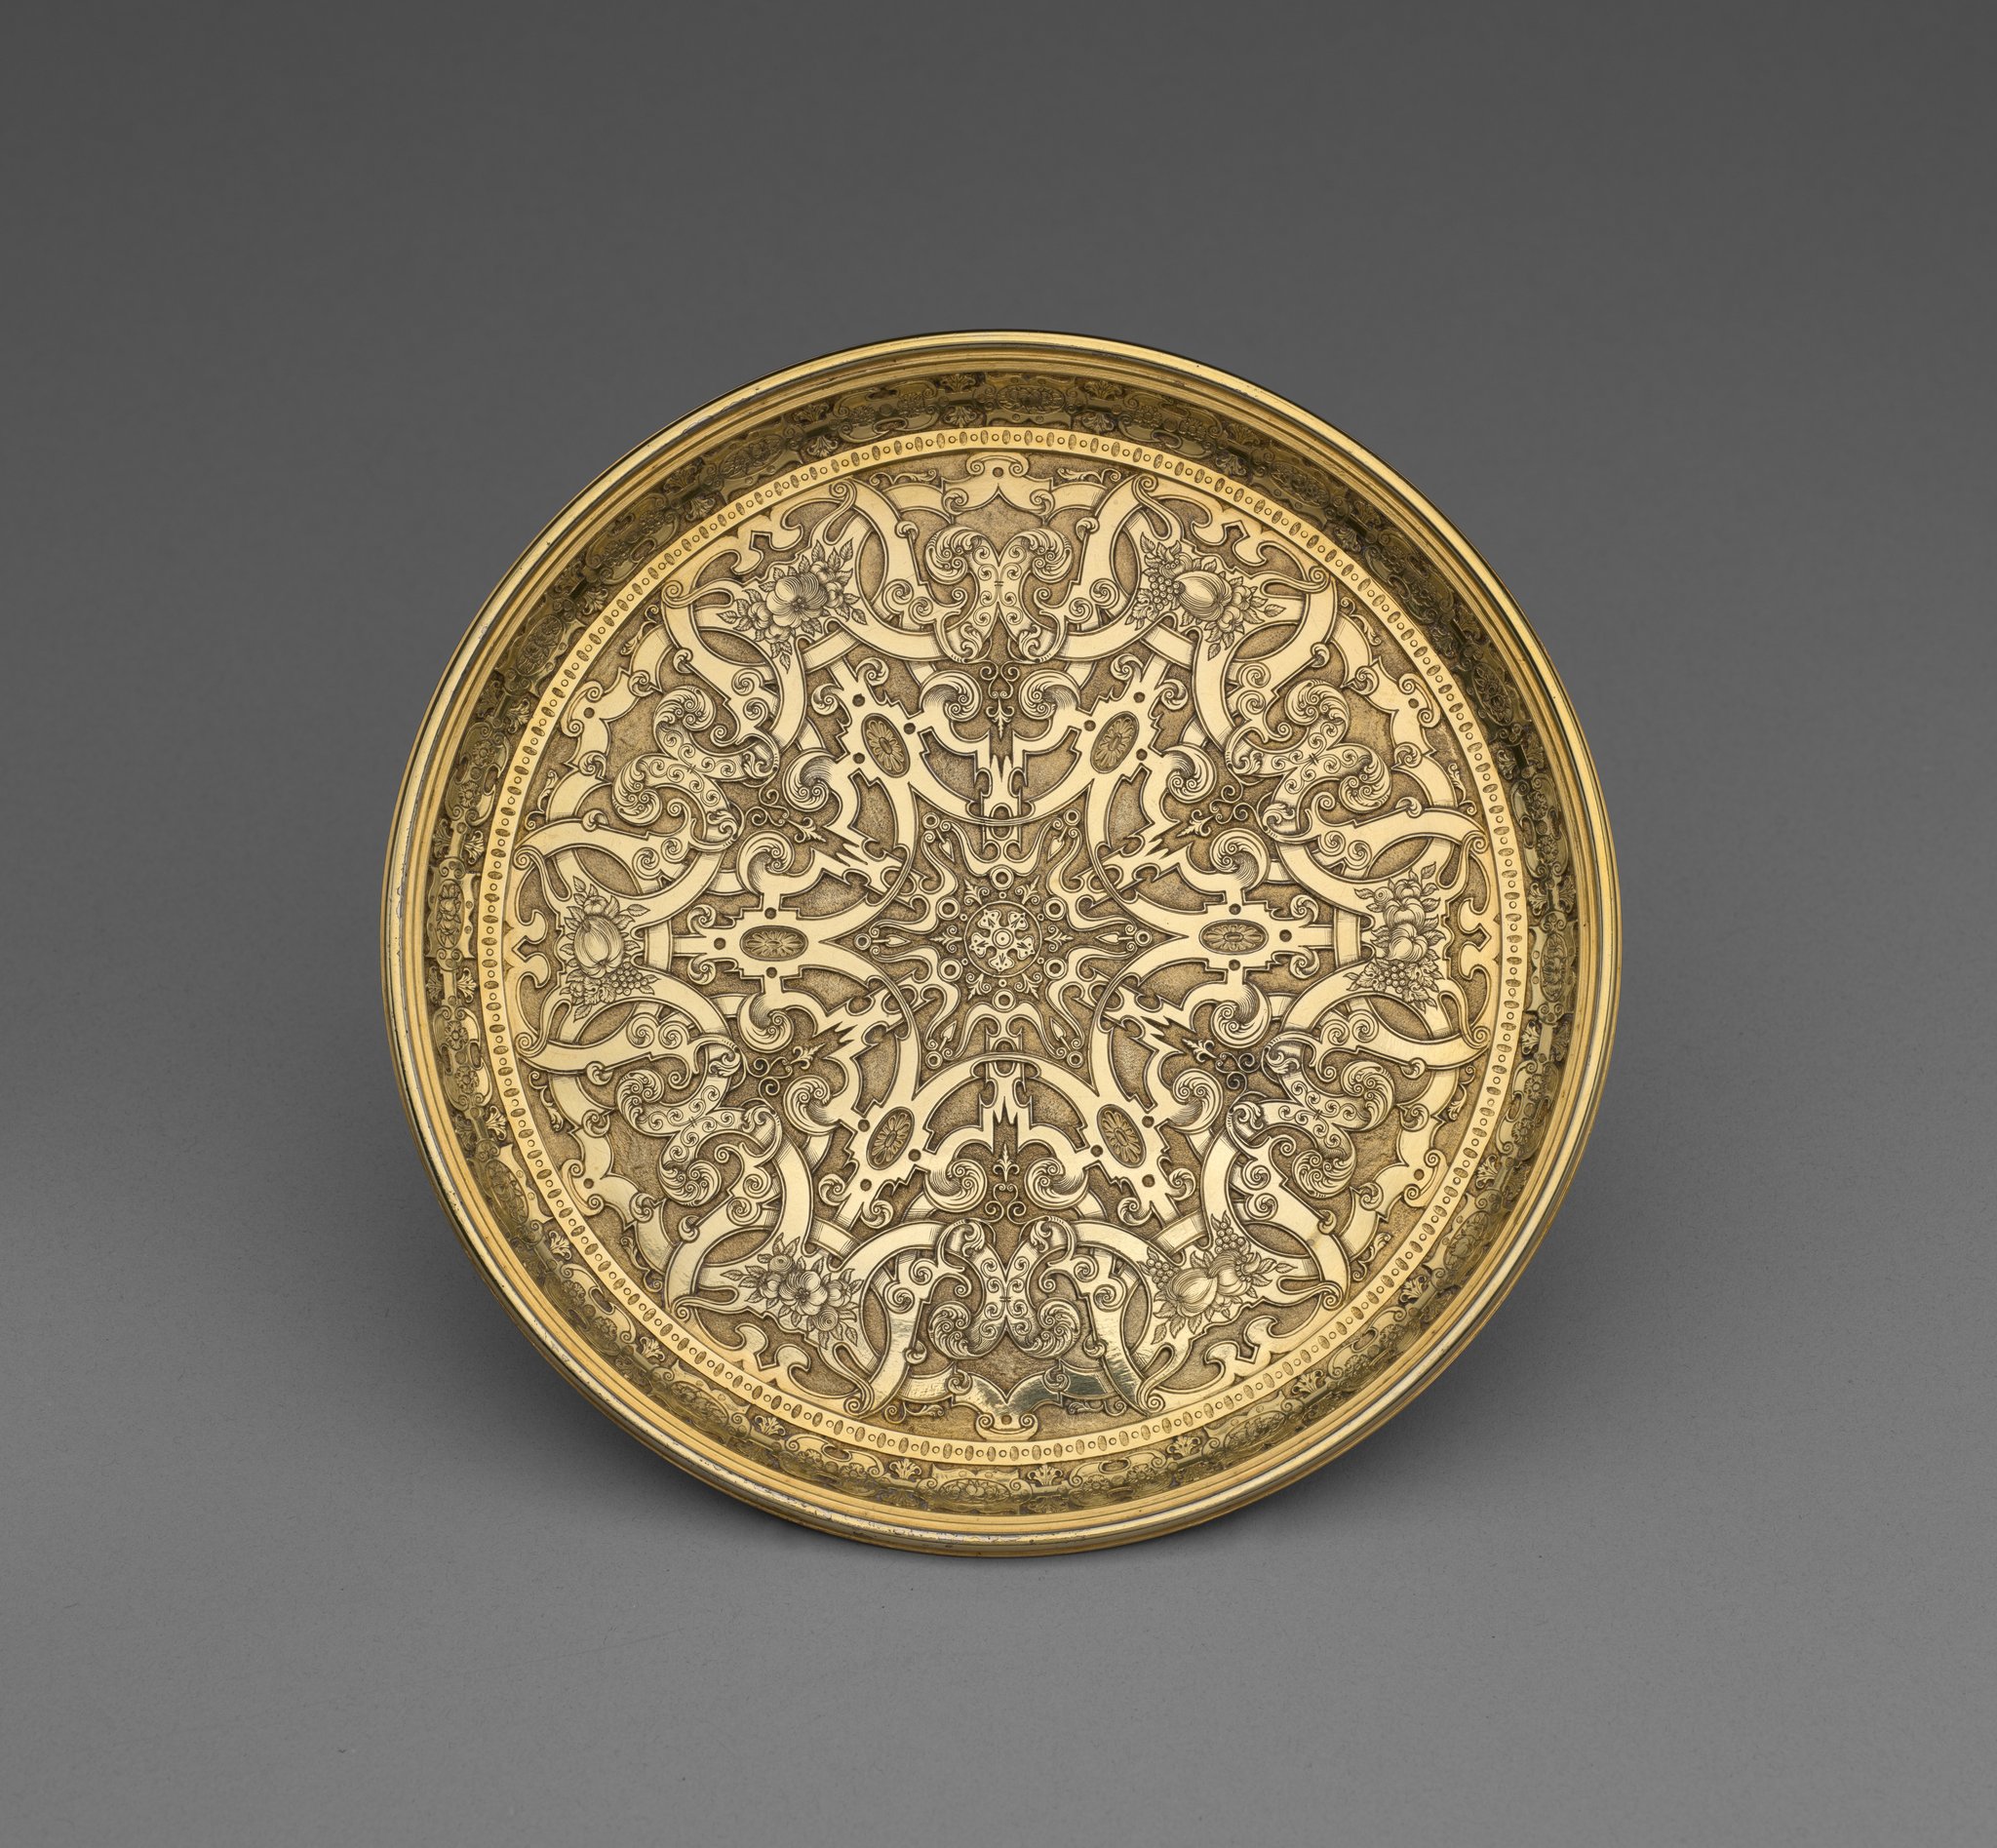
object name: waiter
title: Waiter (one of a pair)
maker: william burwash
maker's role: maker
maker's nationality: british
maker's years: 1782-1820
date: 1817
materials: gilt silver